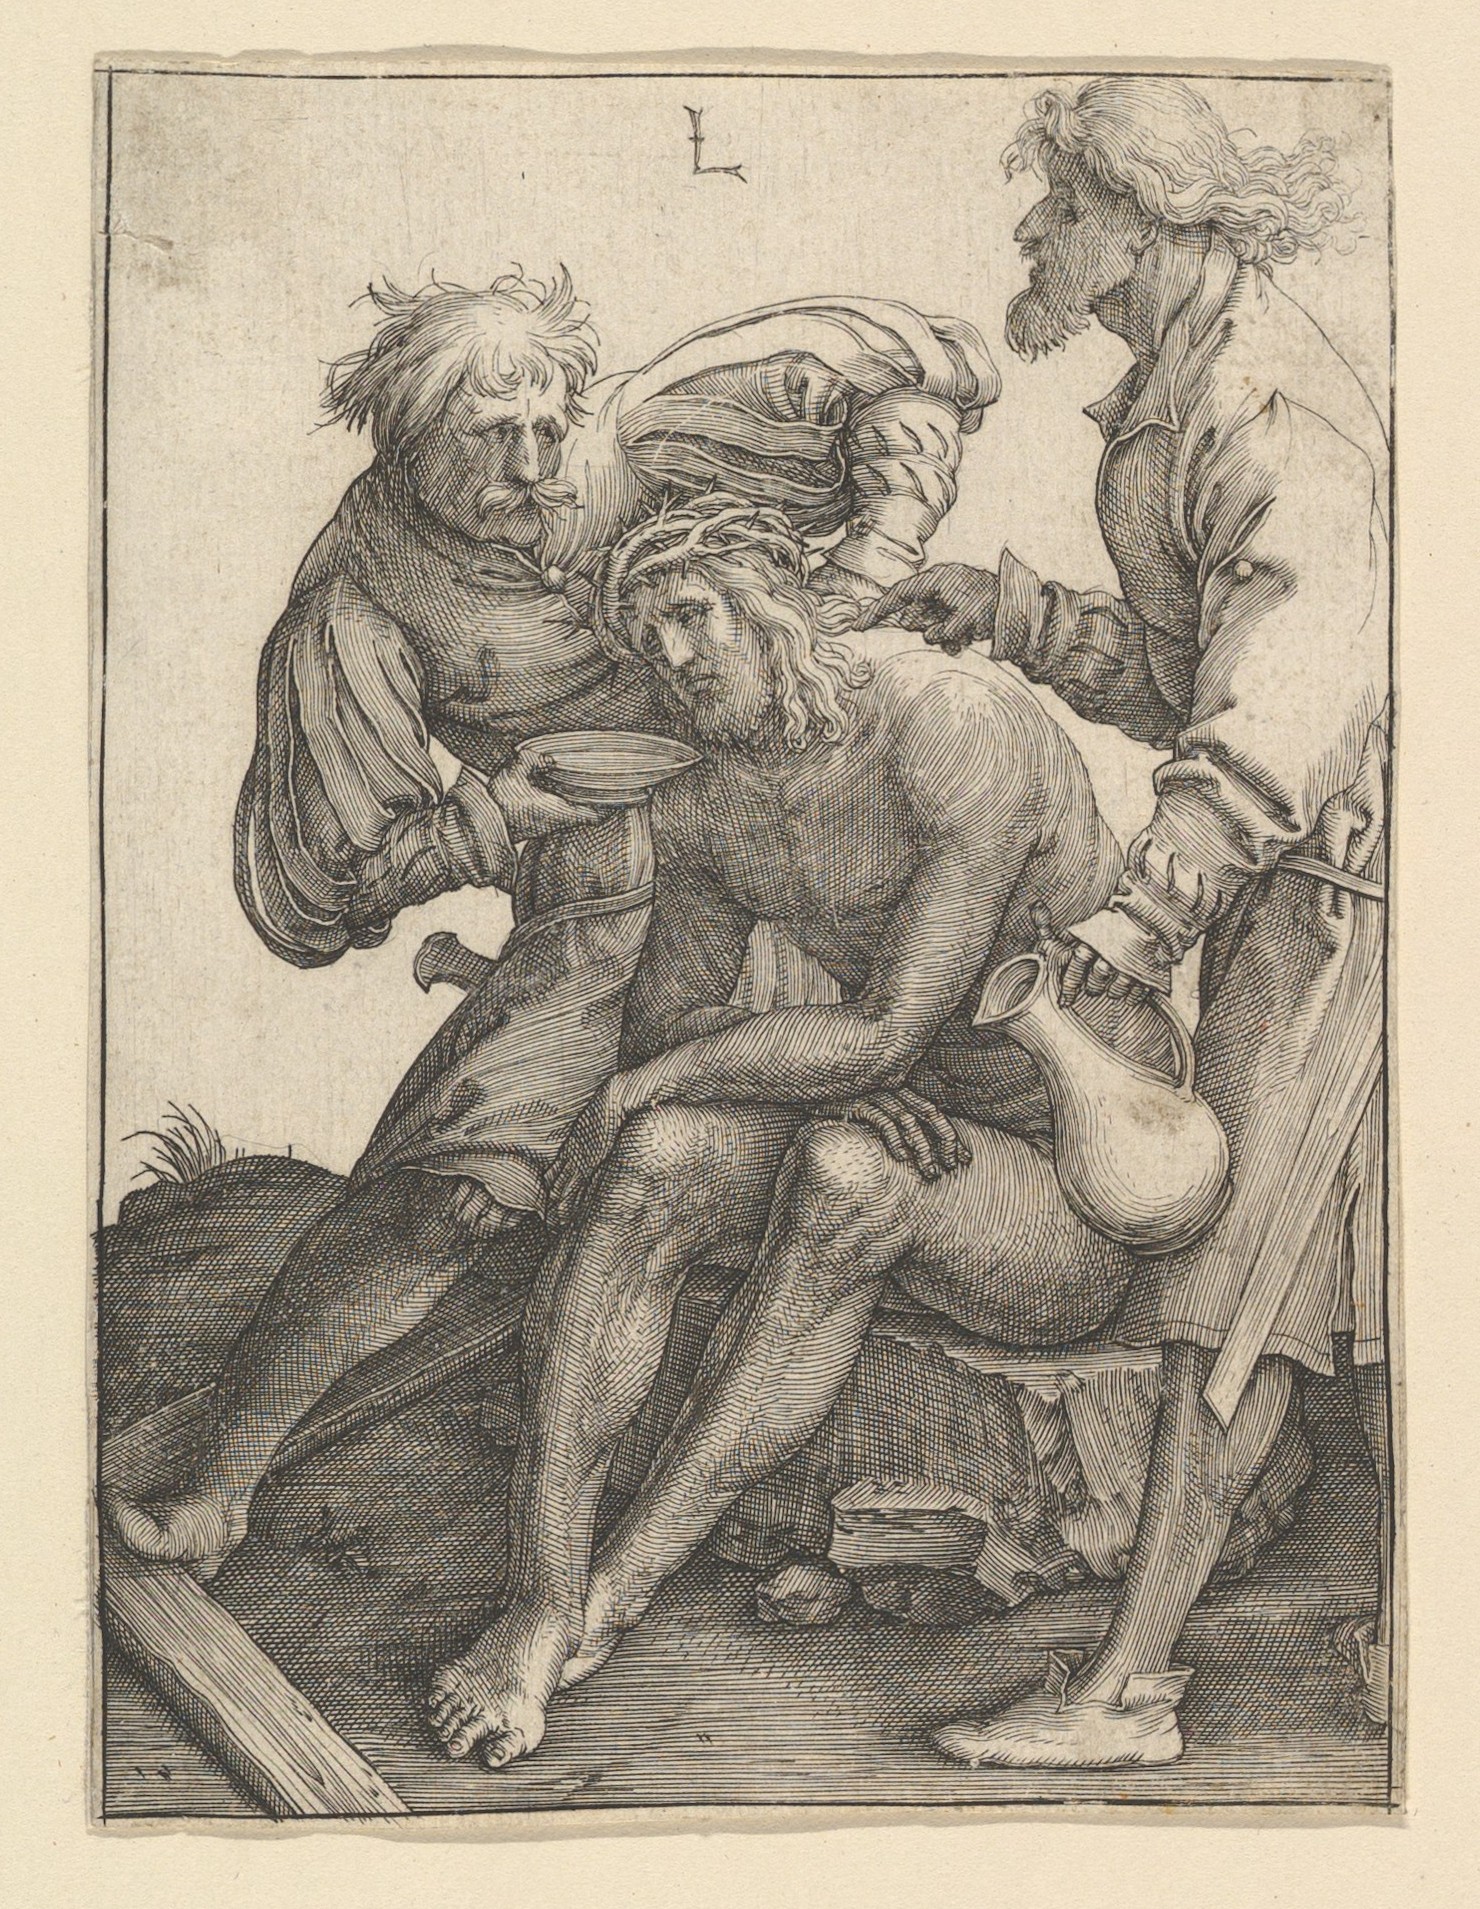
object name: print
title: Soldiers Giving Drink to Christ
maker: lucas van leyden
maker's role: artist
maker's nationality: netherlandish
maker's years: 1494-1533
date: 1512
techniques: engraving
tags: soldiers,men,christ